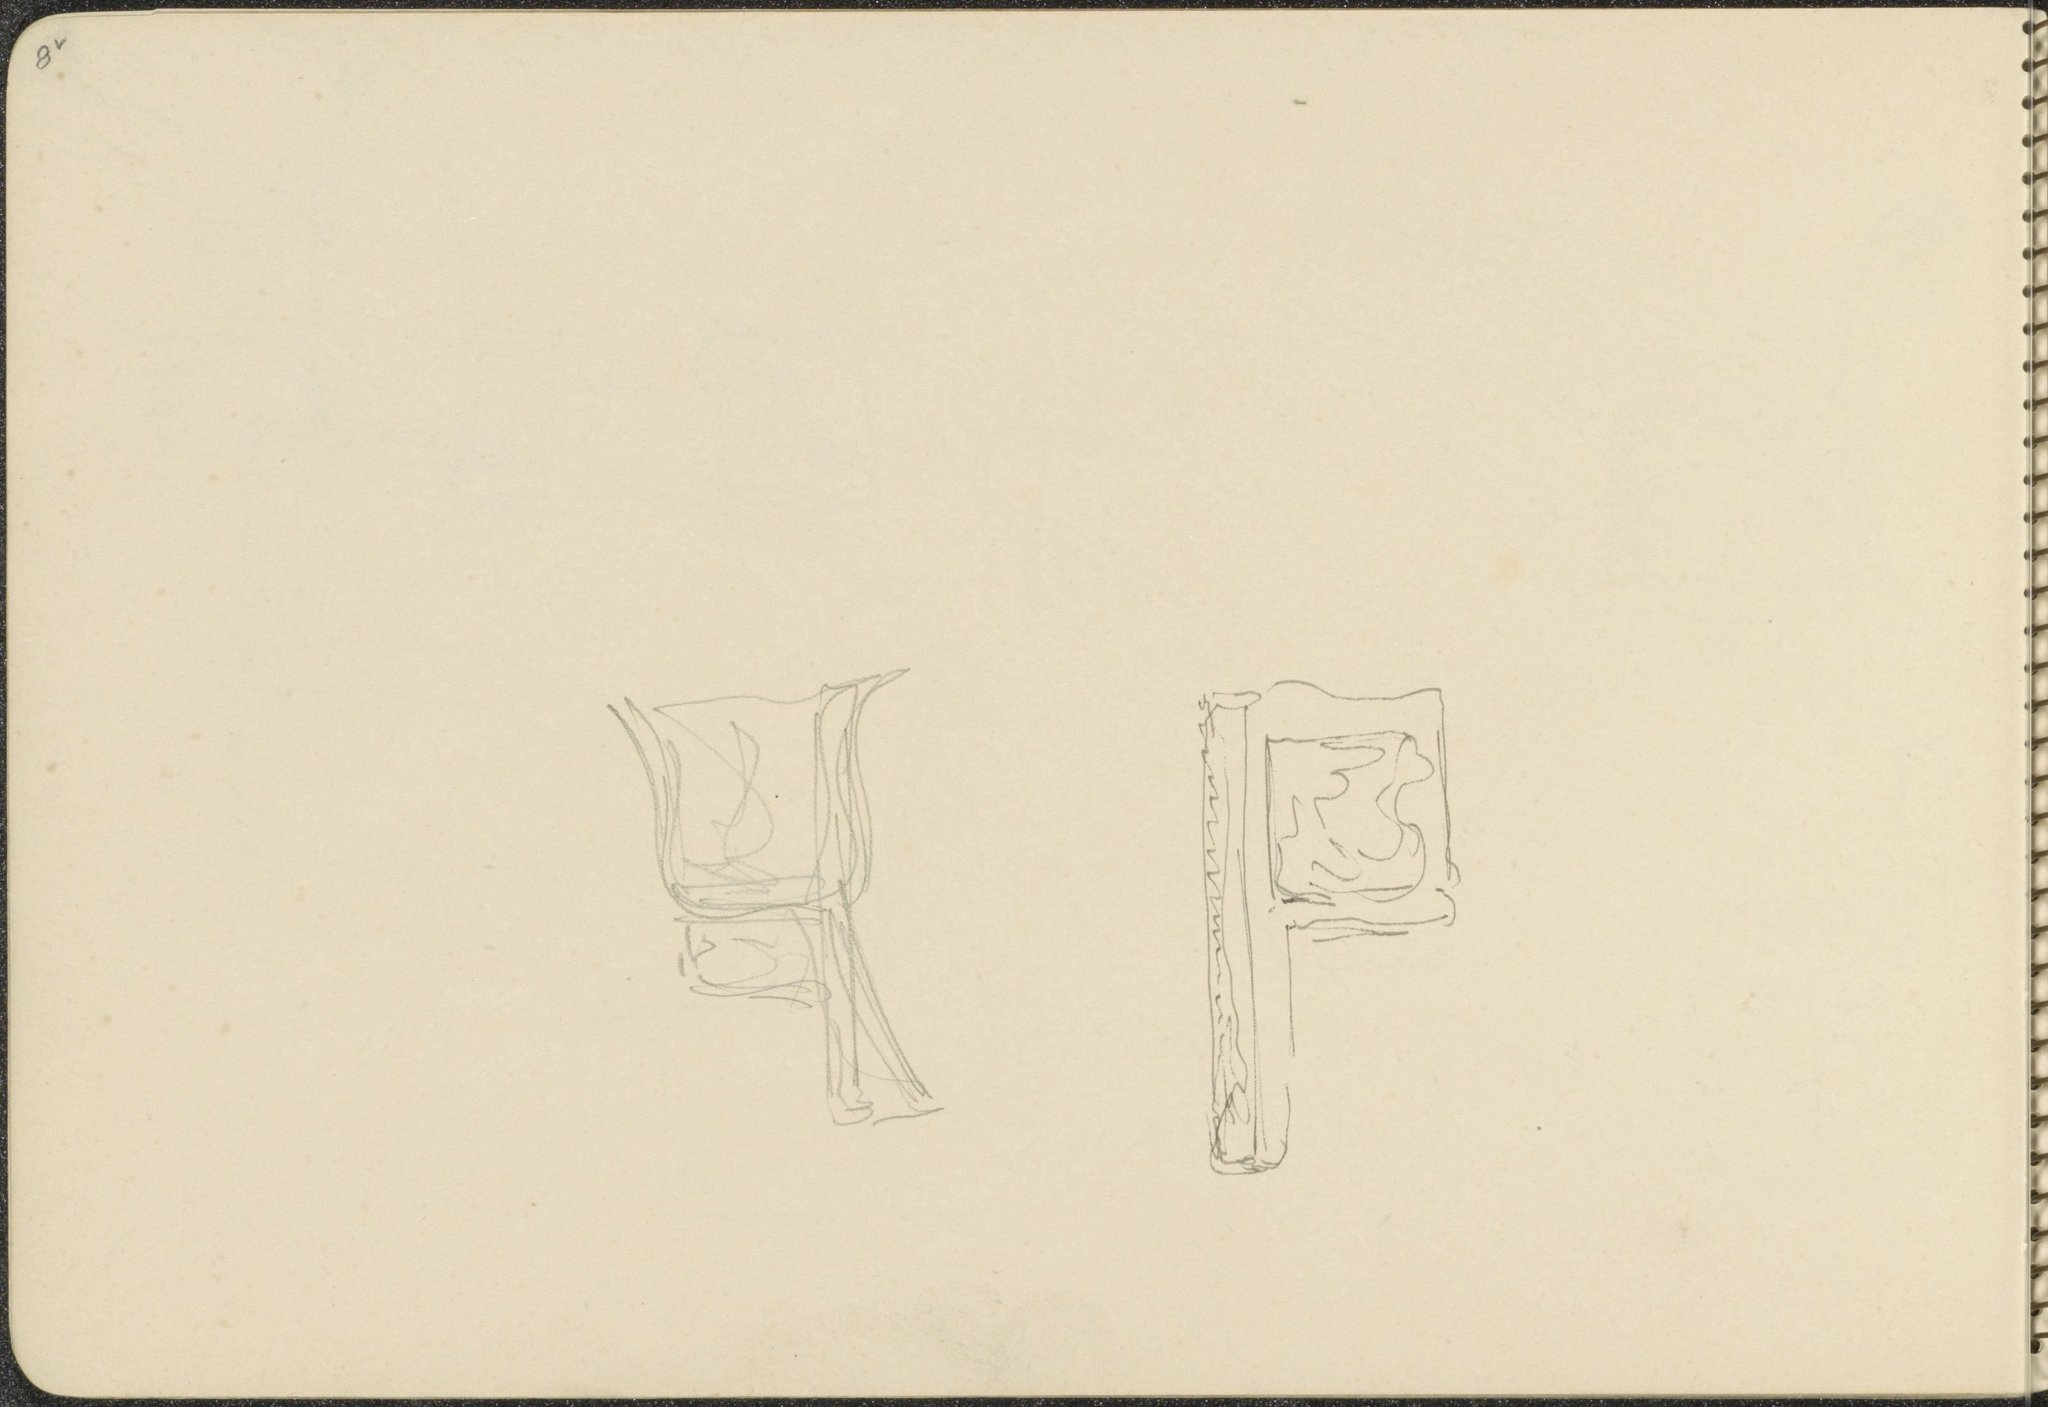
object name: sketchbook leaf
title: Twee stoelen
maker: carel adolph lion cachet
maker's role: draughtsman, print maker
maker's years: 1864-1945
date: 1934-1943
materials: ink, paper, pencil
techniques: pen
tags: chair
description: Blad 8 verso uit een schetsboek met 19 bladen.